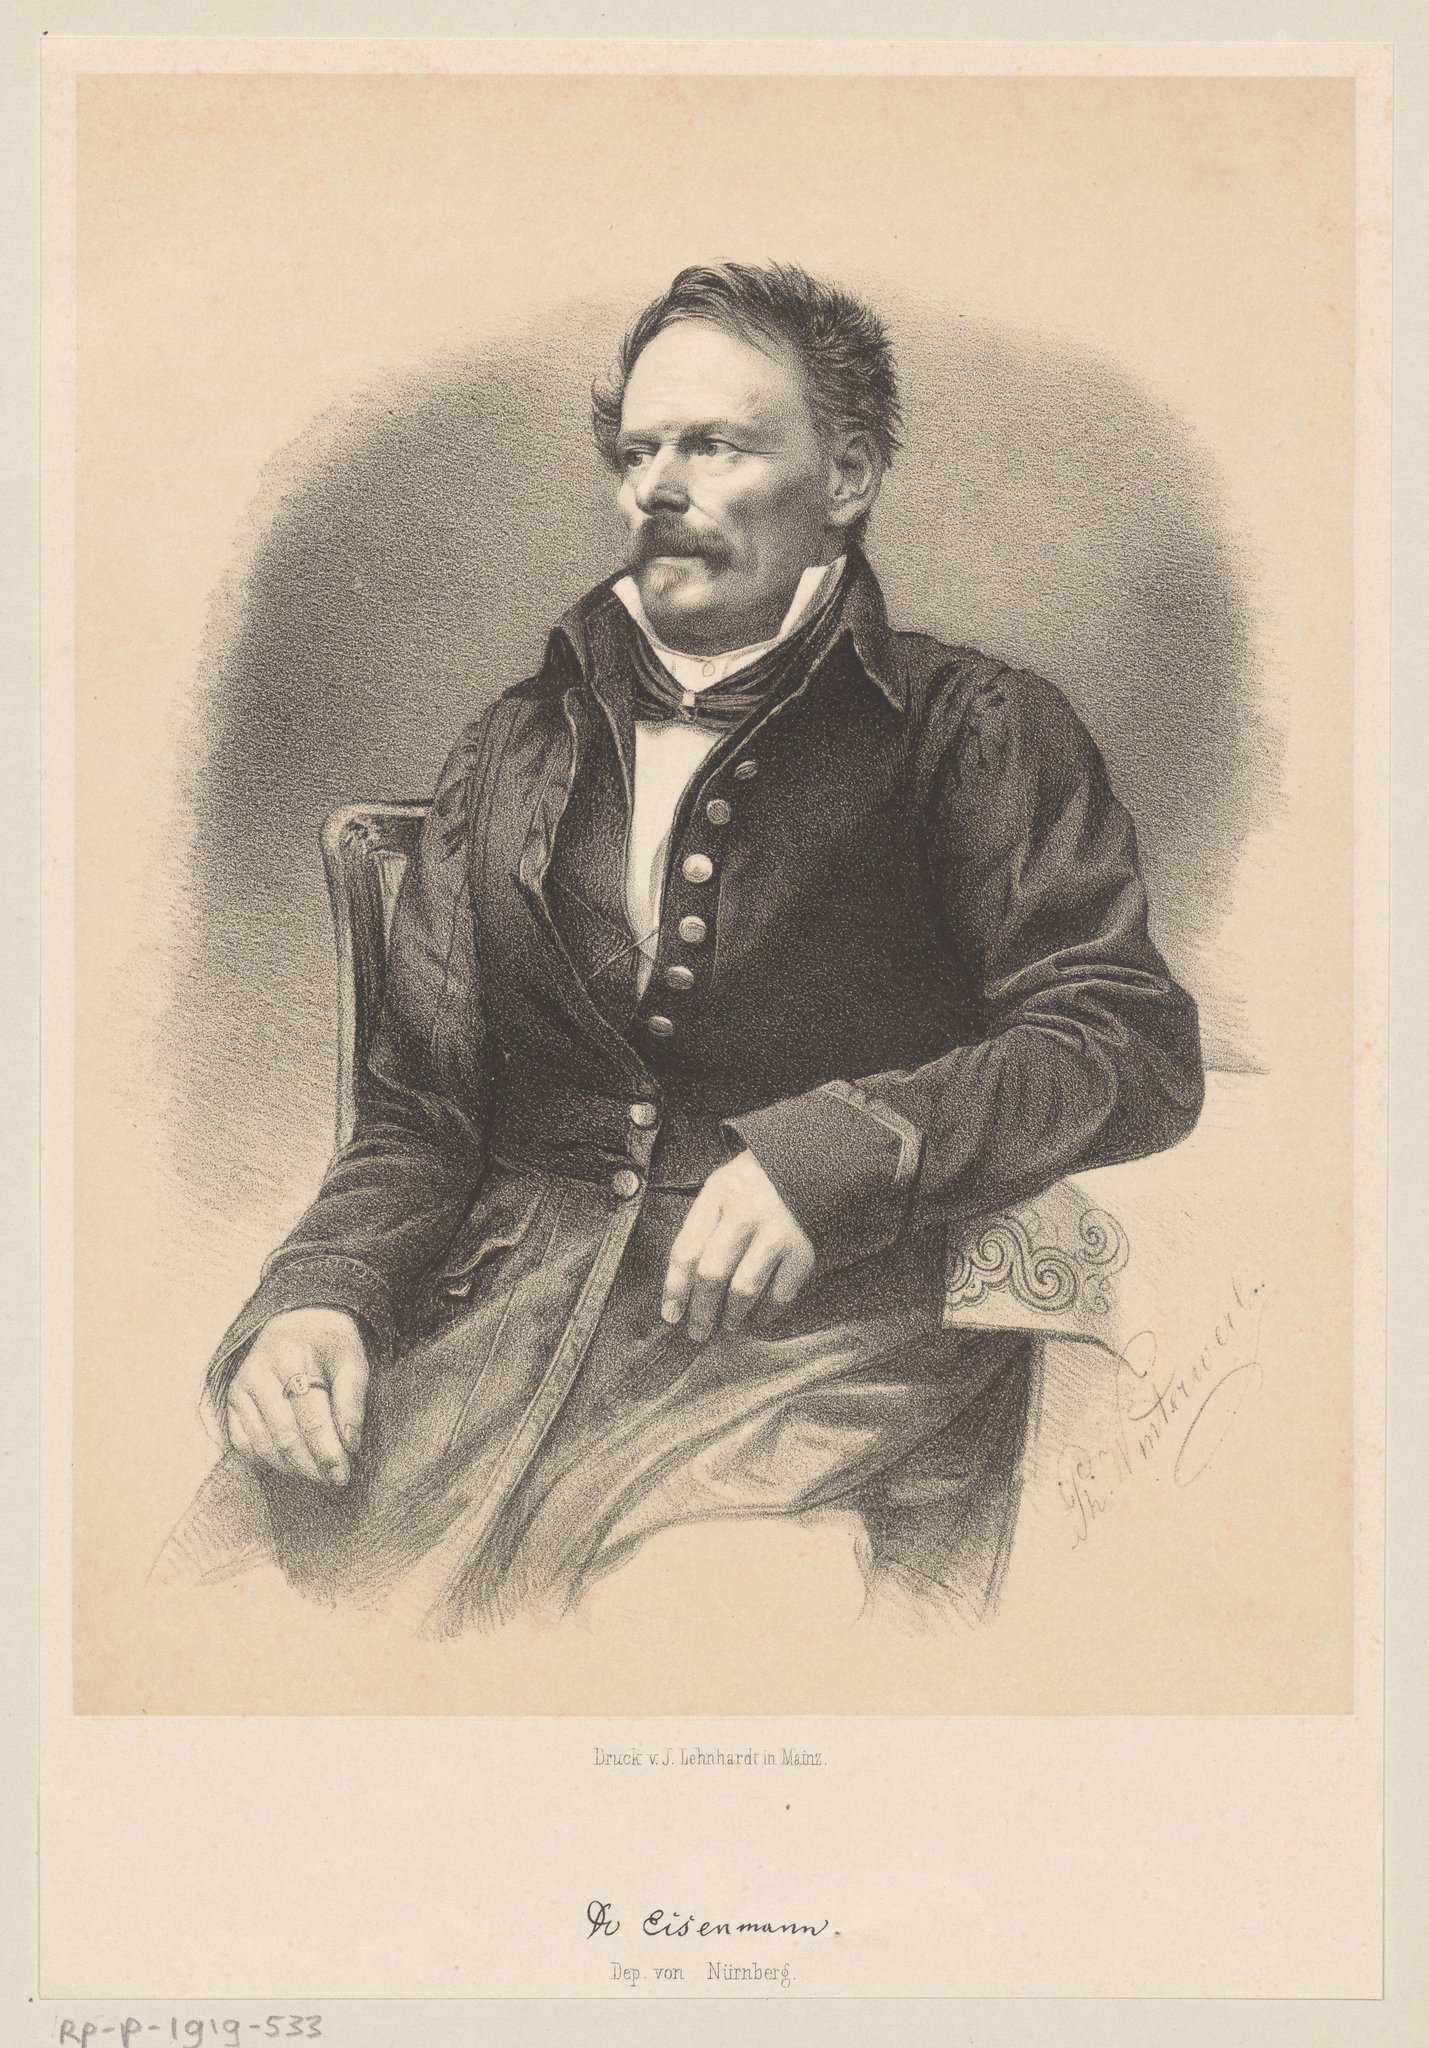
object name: print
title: Portret van Gottfried Eisenmann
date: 1848-1862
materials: paper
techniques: lithograph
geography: mainz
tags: politician, historical persons, politician, e.g. party leader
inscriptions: collector's mark: Lugt 2228